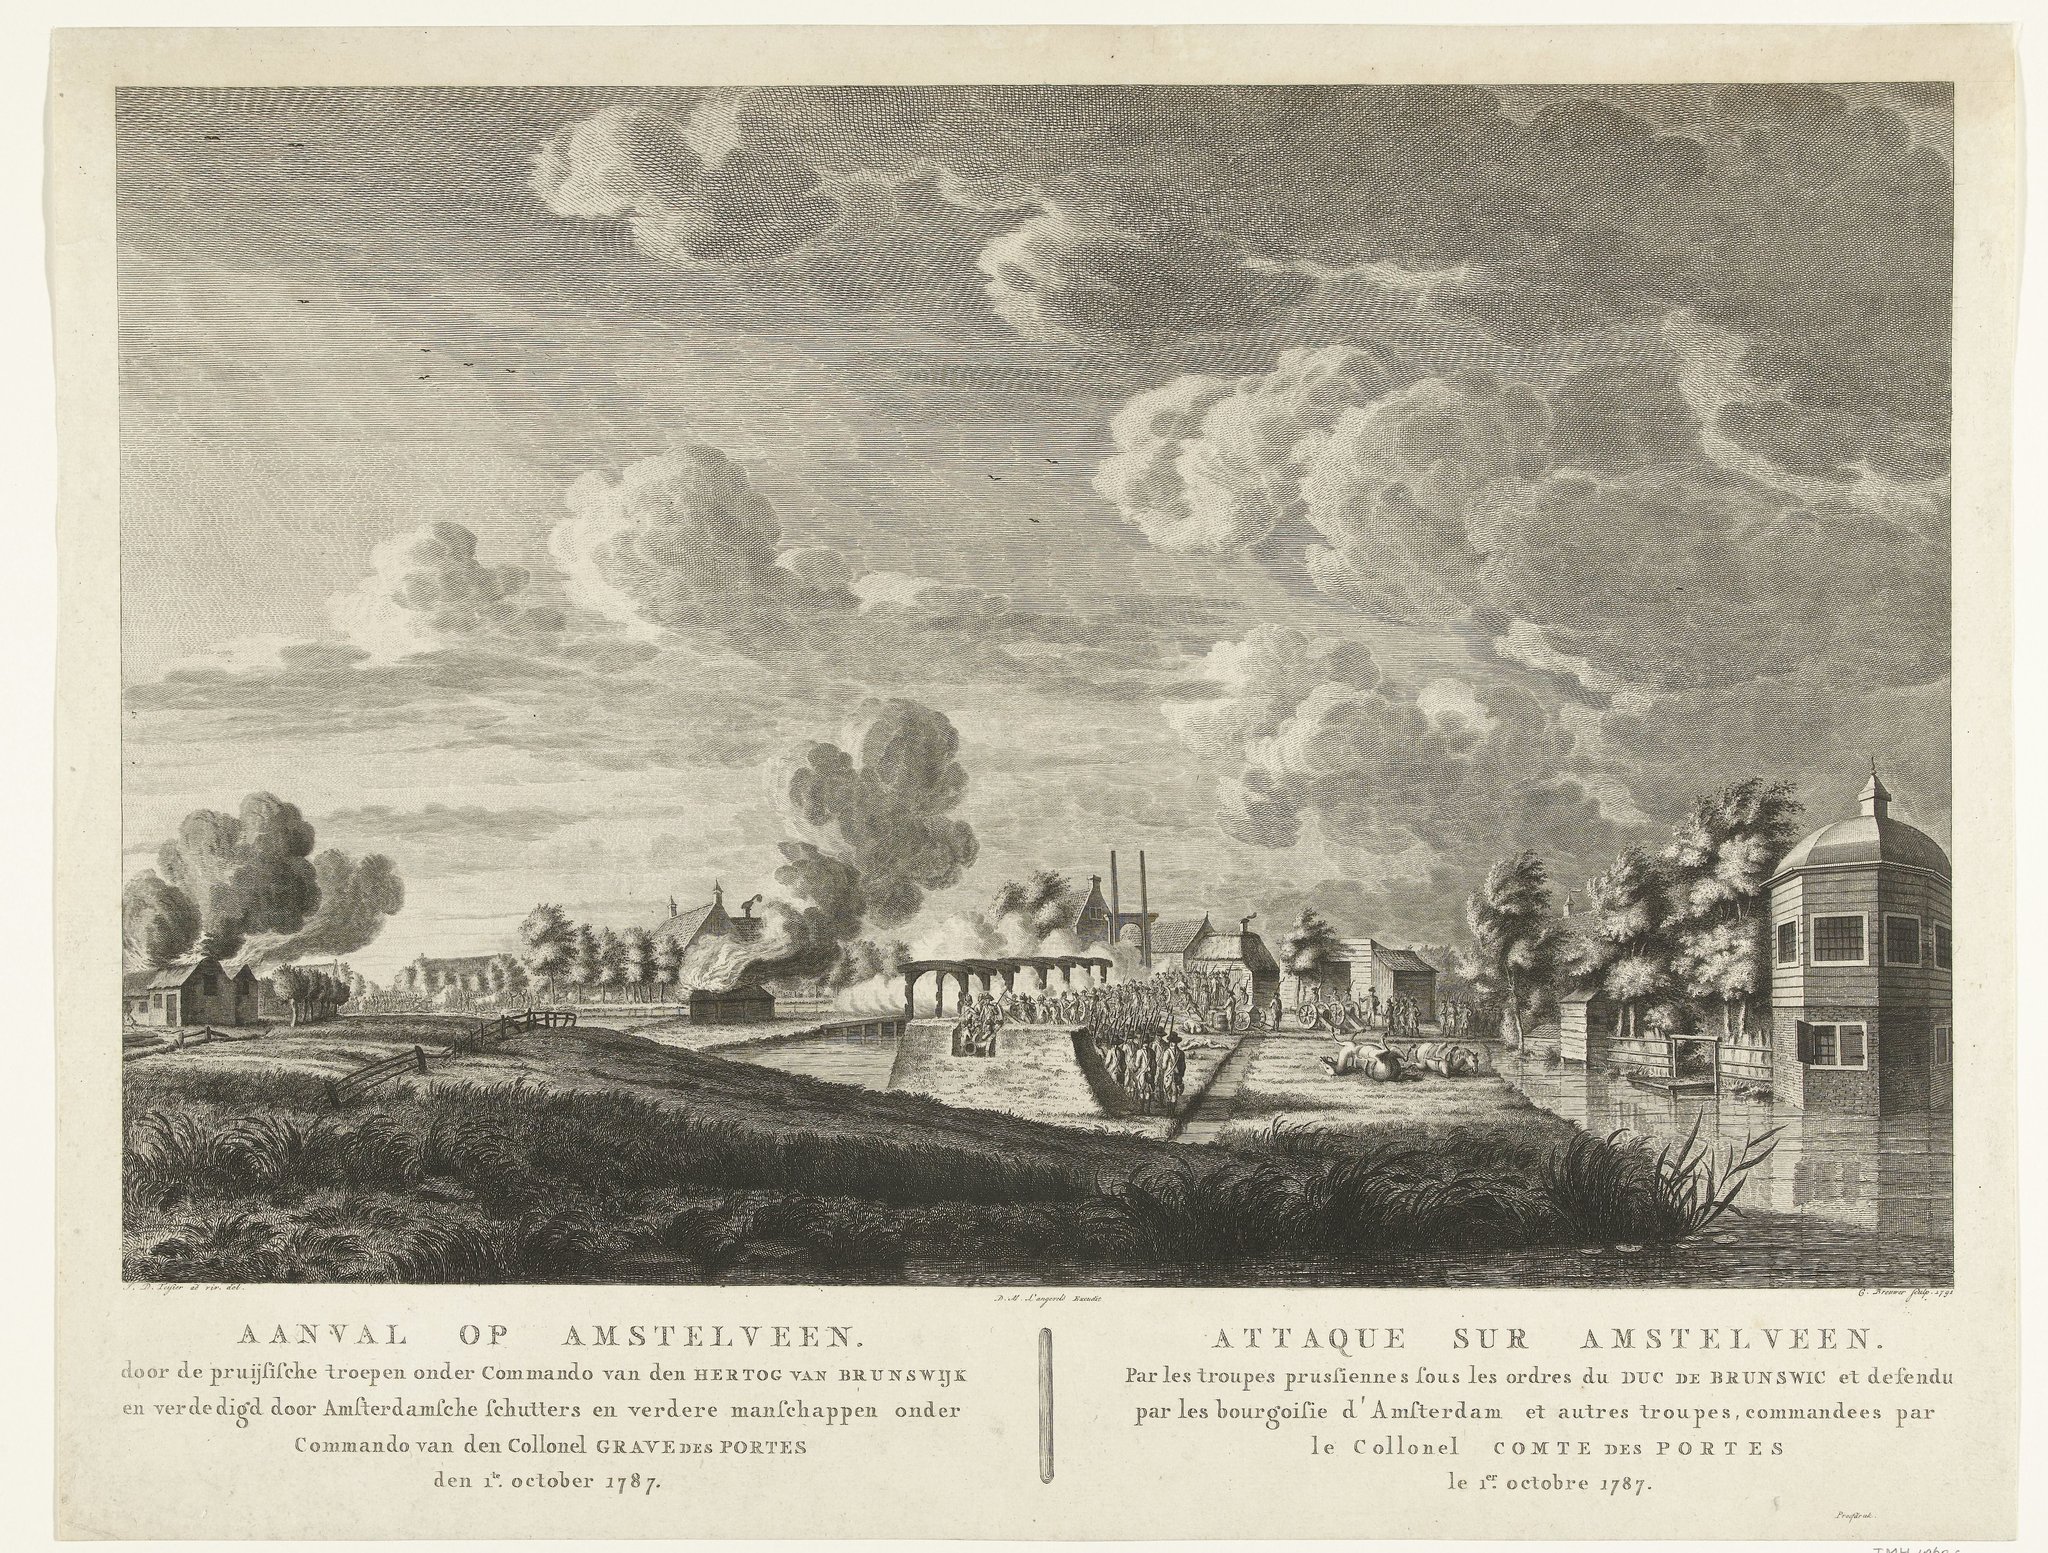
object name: print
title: Pruisische troepen vallen Amstelveen aan dat wordt verdedigd door Amsterdamse schutters op 1 oktober 1787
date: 1791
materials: paper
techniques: engraving, etching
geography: netherlands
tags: (military) attack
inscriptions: collector's mark: Lugt 2228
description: Aanval op Amstelveen: gezicht op water en enkele huizen en rechts een koepel: de Pruisische troepen o.l.v. de hertog van Brunswijk vallen aan en de Amsterdamse schutters o.l.v. kolonel Graver des Porte verdedigen.